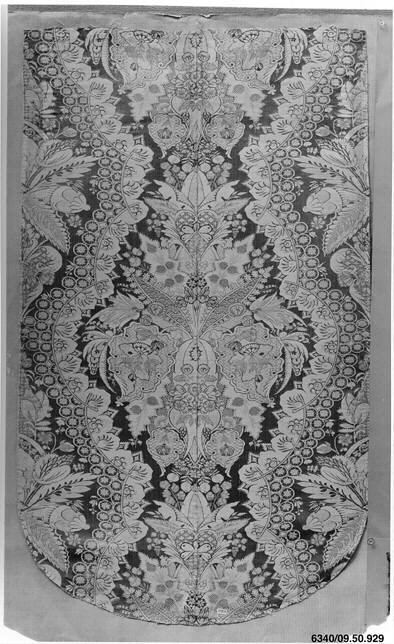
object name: piece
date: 1720-1725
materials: silk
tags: leaves